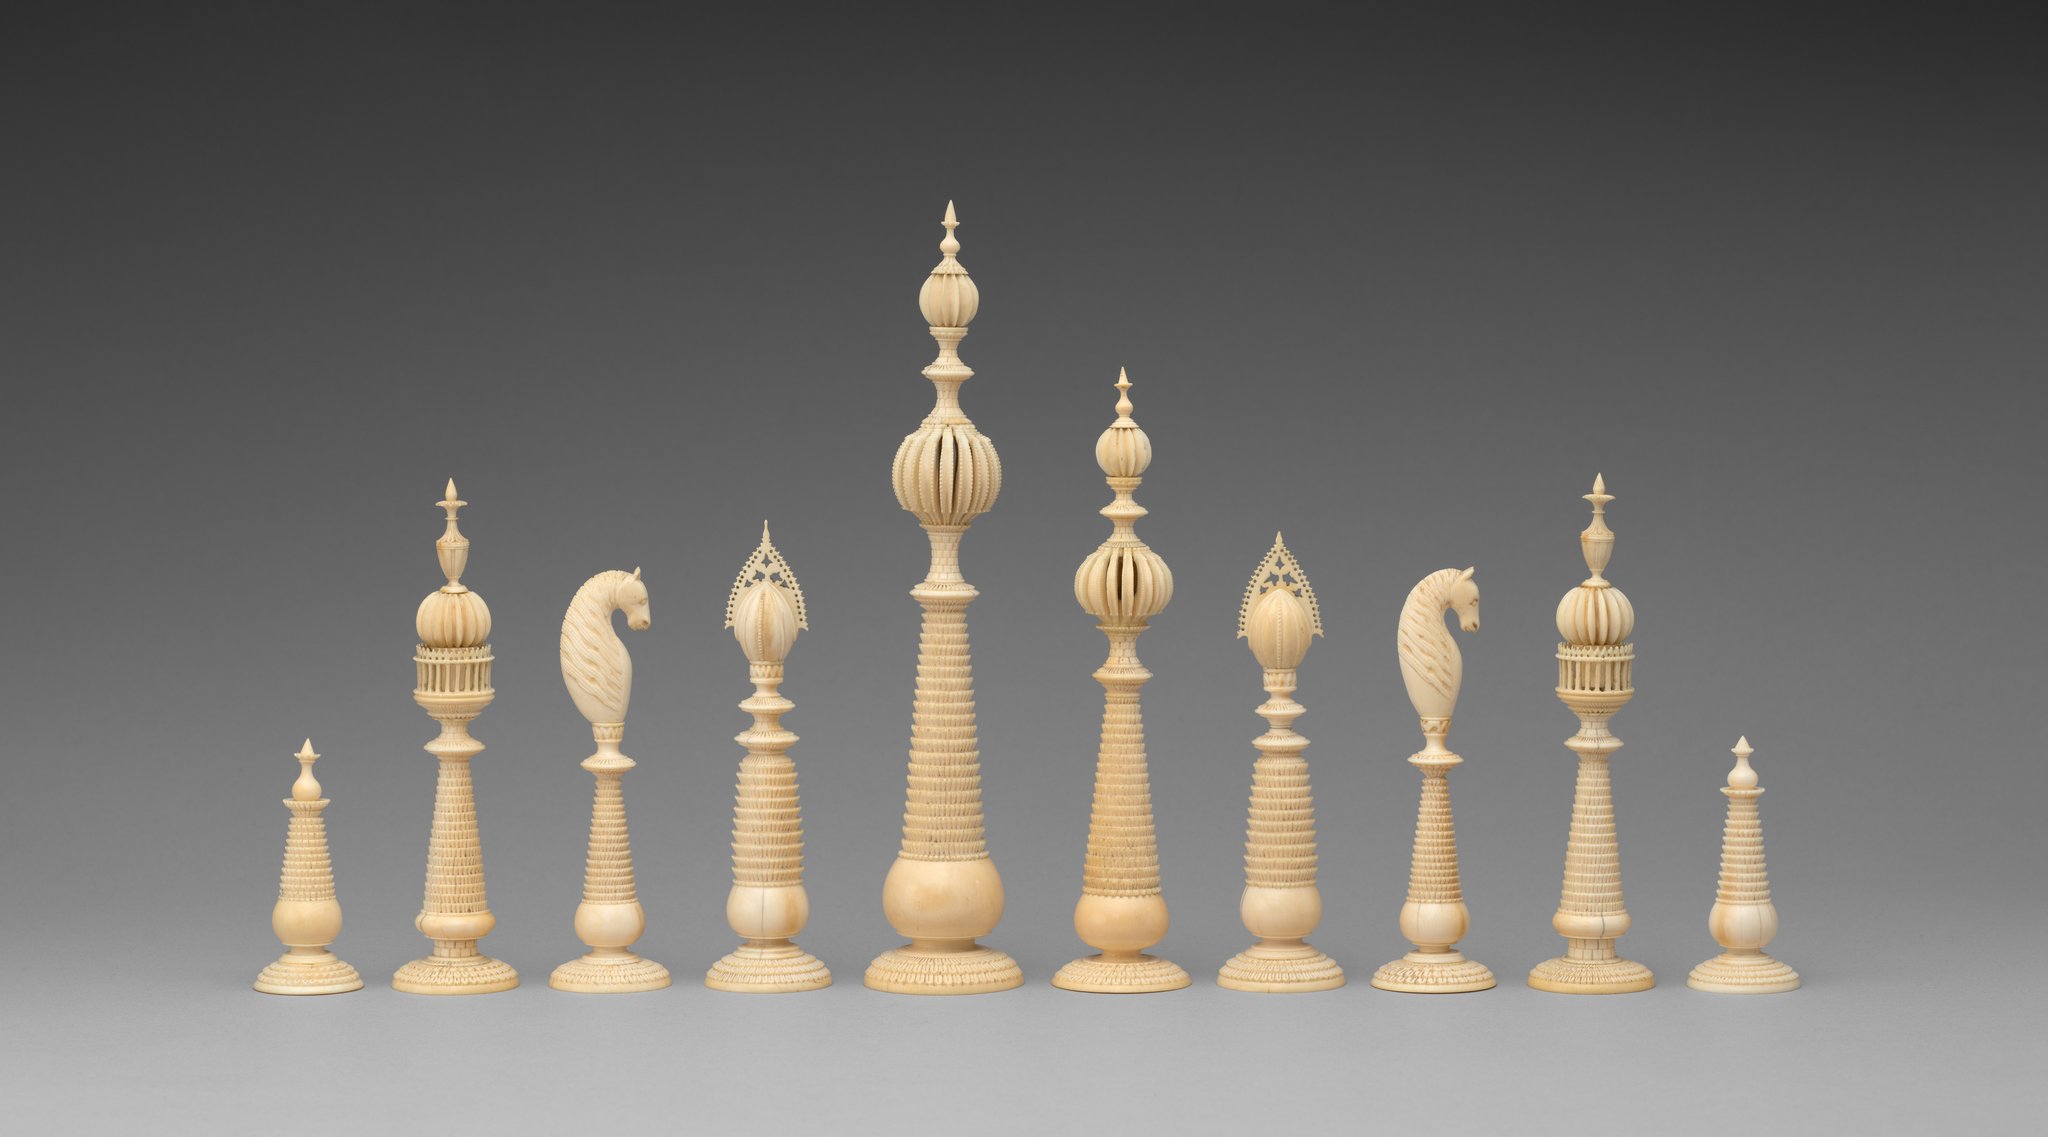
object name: chessman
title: Chessmen (32)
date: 1801-1900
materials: ivory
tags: chess,games